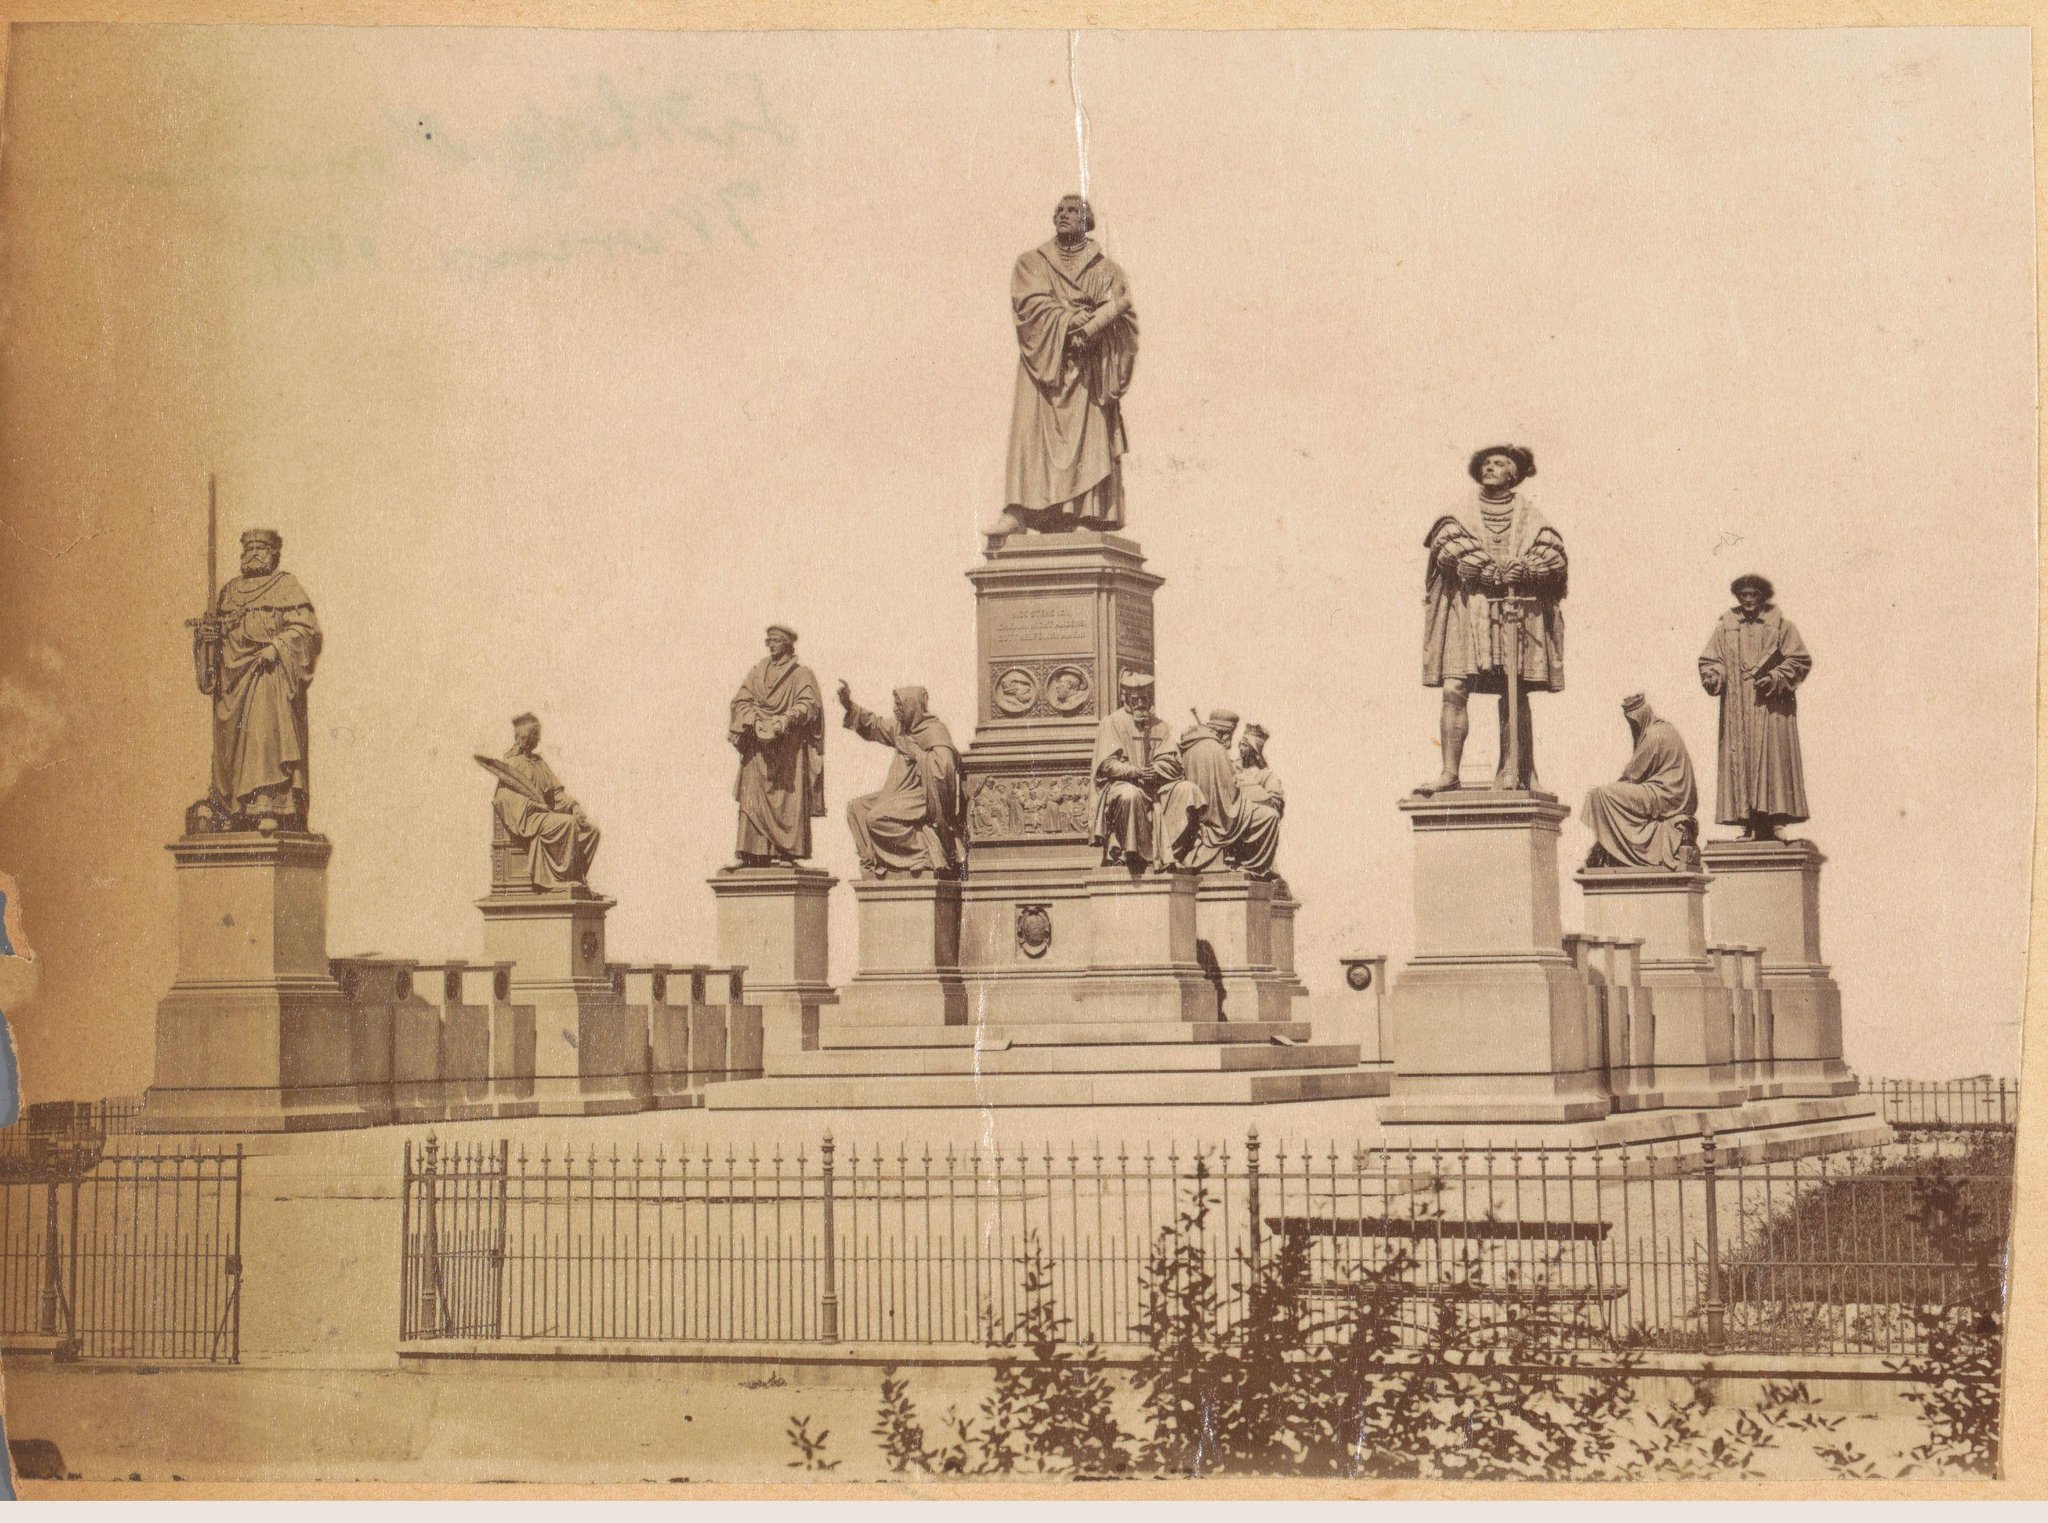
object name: photograph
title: Monument voor Martin Luther in Worms, Duitsland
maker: Anonymous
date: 1868-1900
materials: cardboard, paper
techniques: albumen print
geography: worms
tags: priest, martin luther, monument, statue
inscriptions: inscription: ‘Luthers Monument Worms’